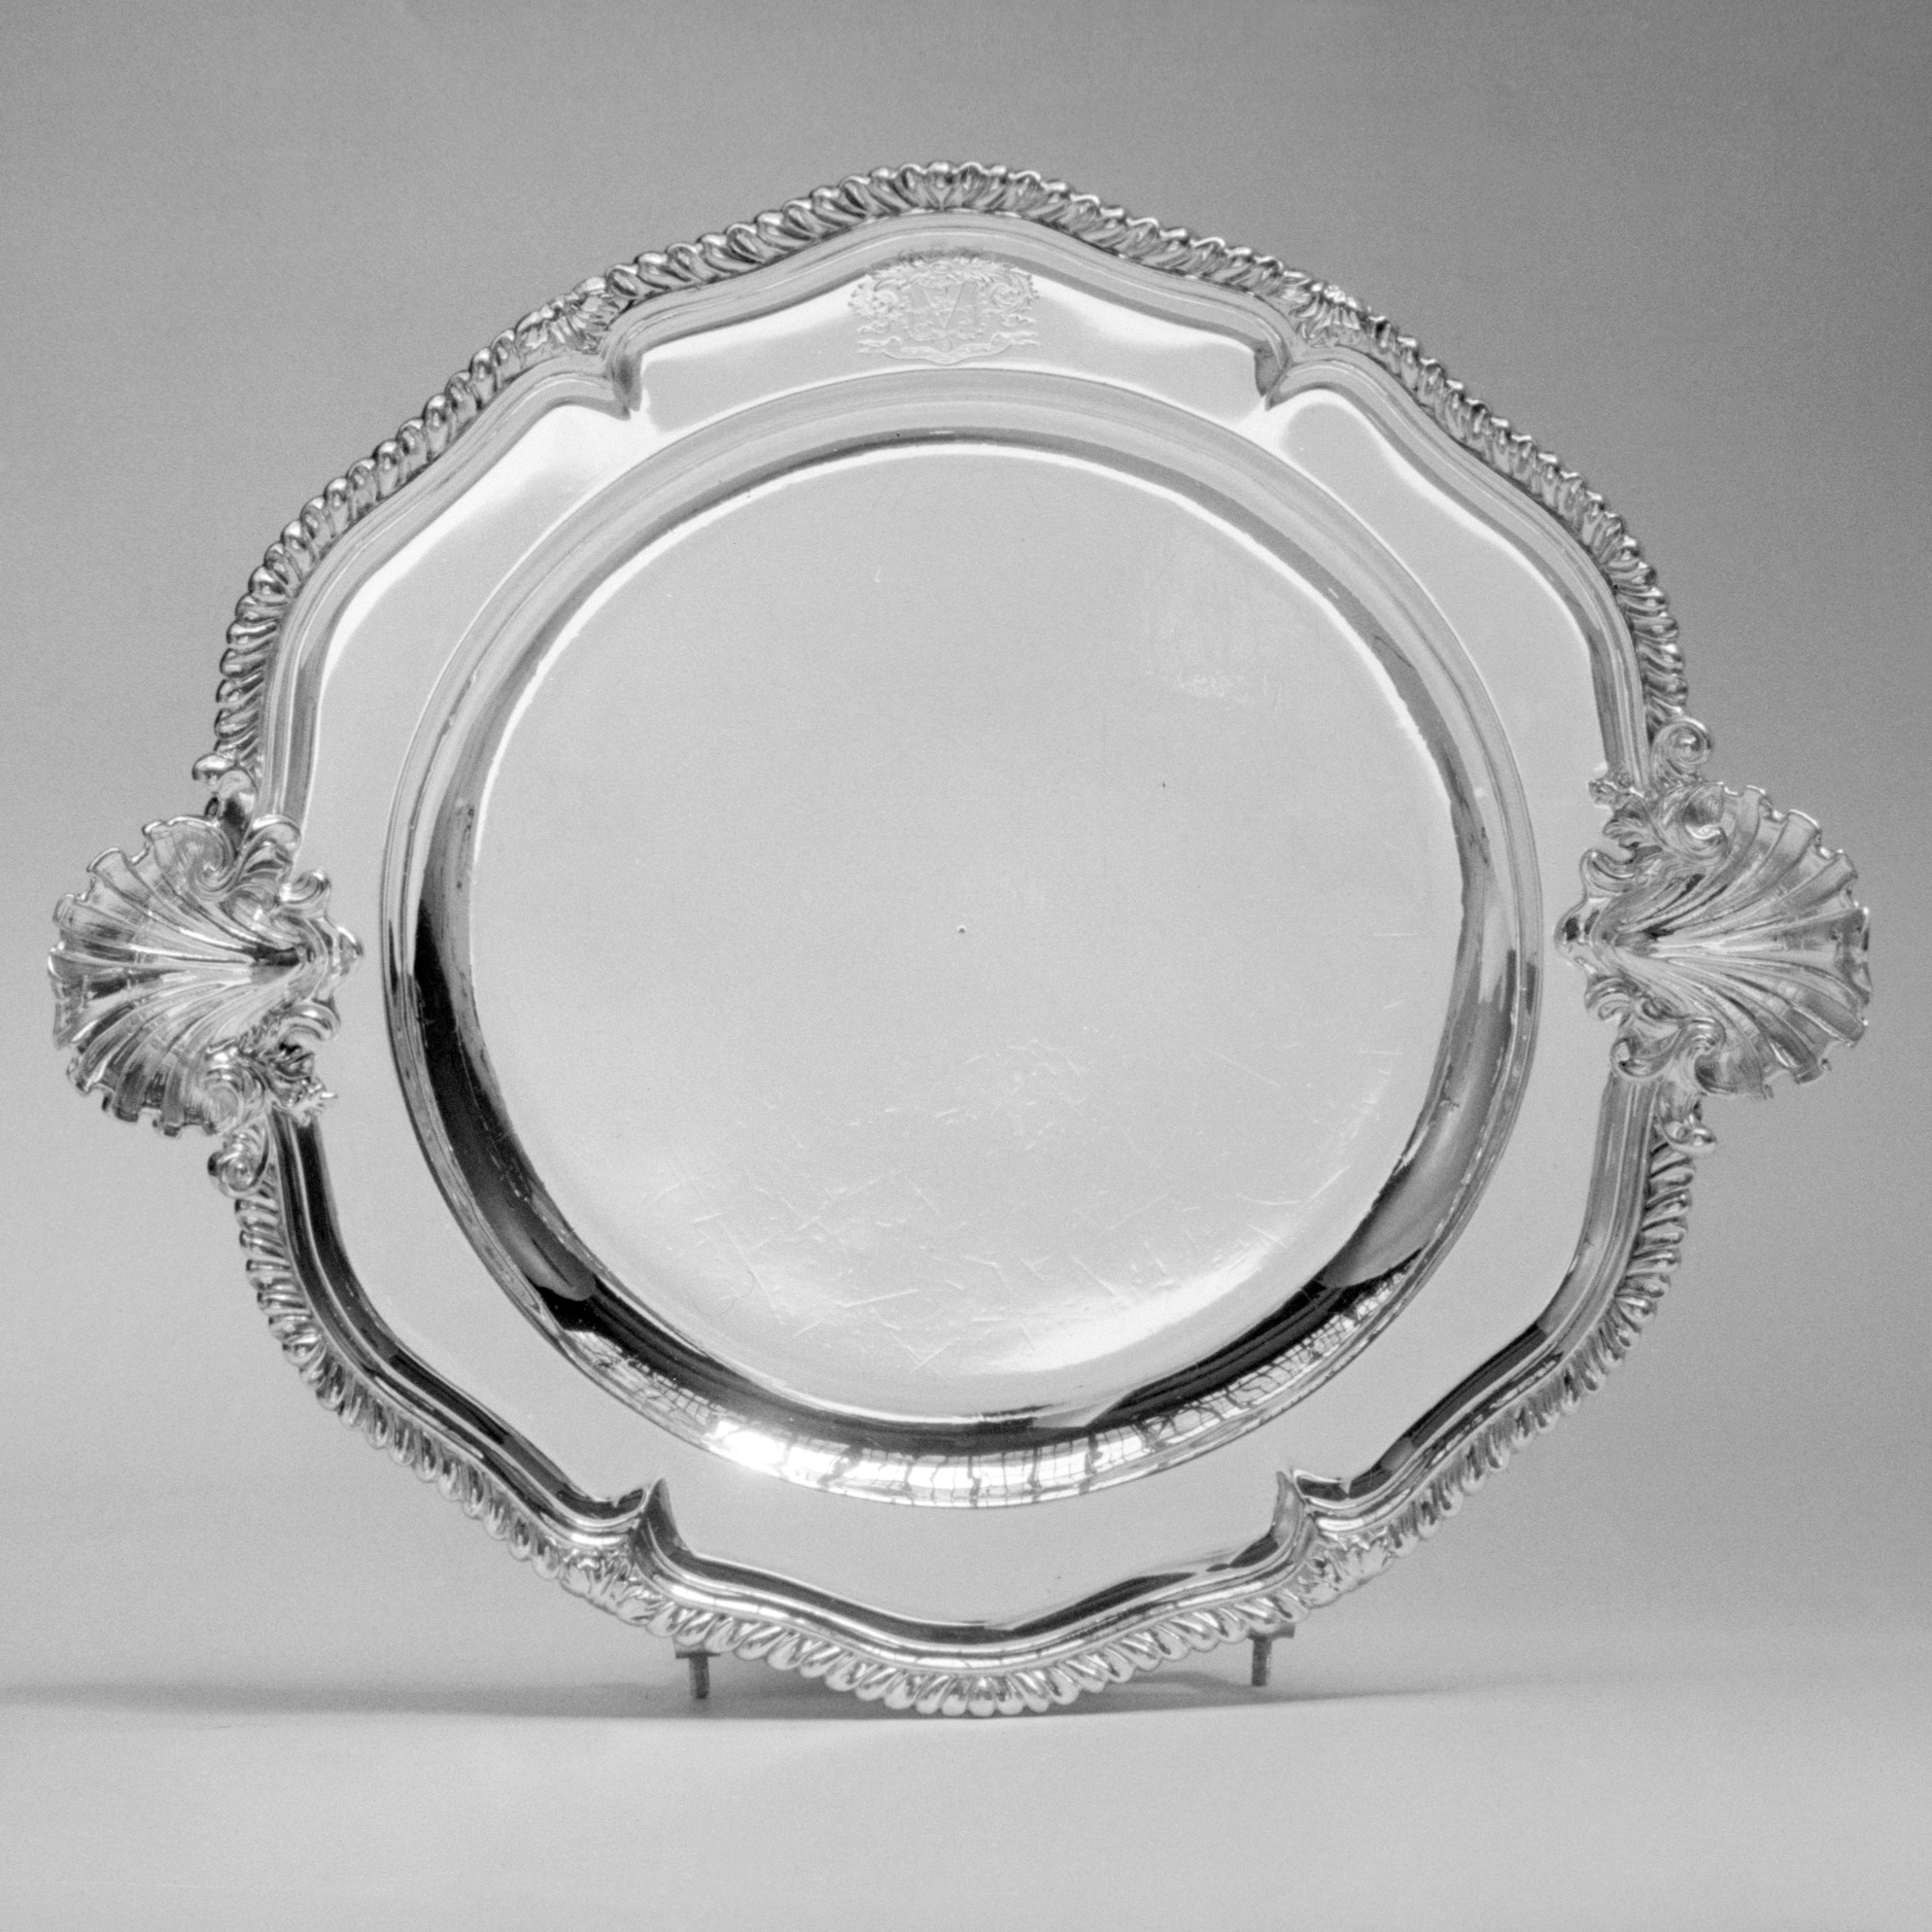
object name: dish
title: Dish (one of a graduated set of seven)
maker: paul de lamerie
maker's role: maker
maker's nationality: british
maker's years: 1688-1751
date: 1741-1742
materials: silver